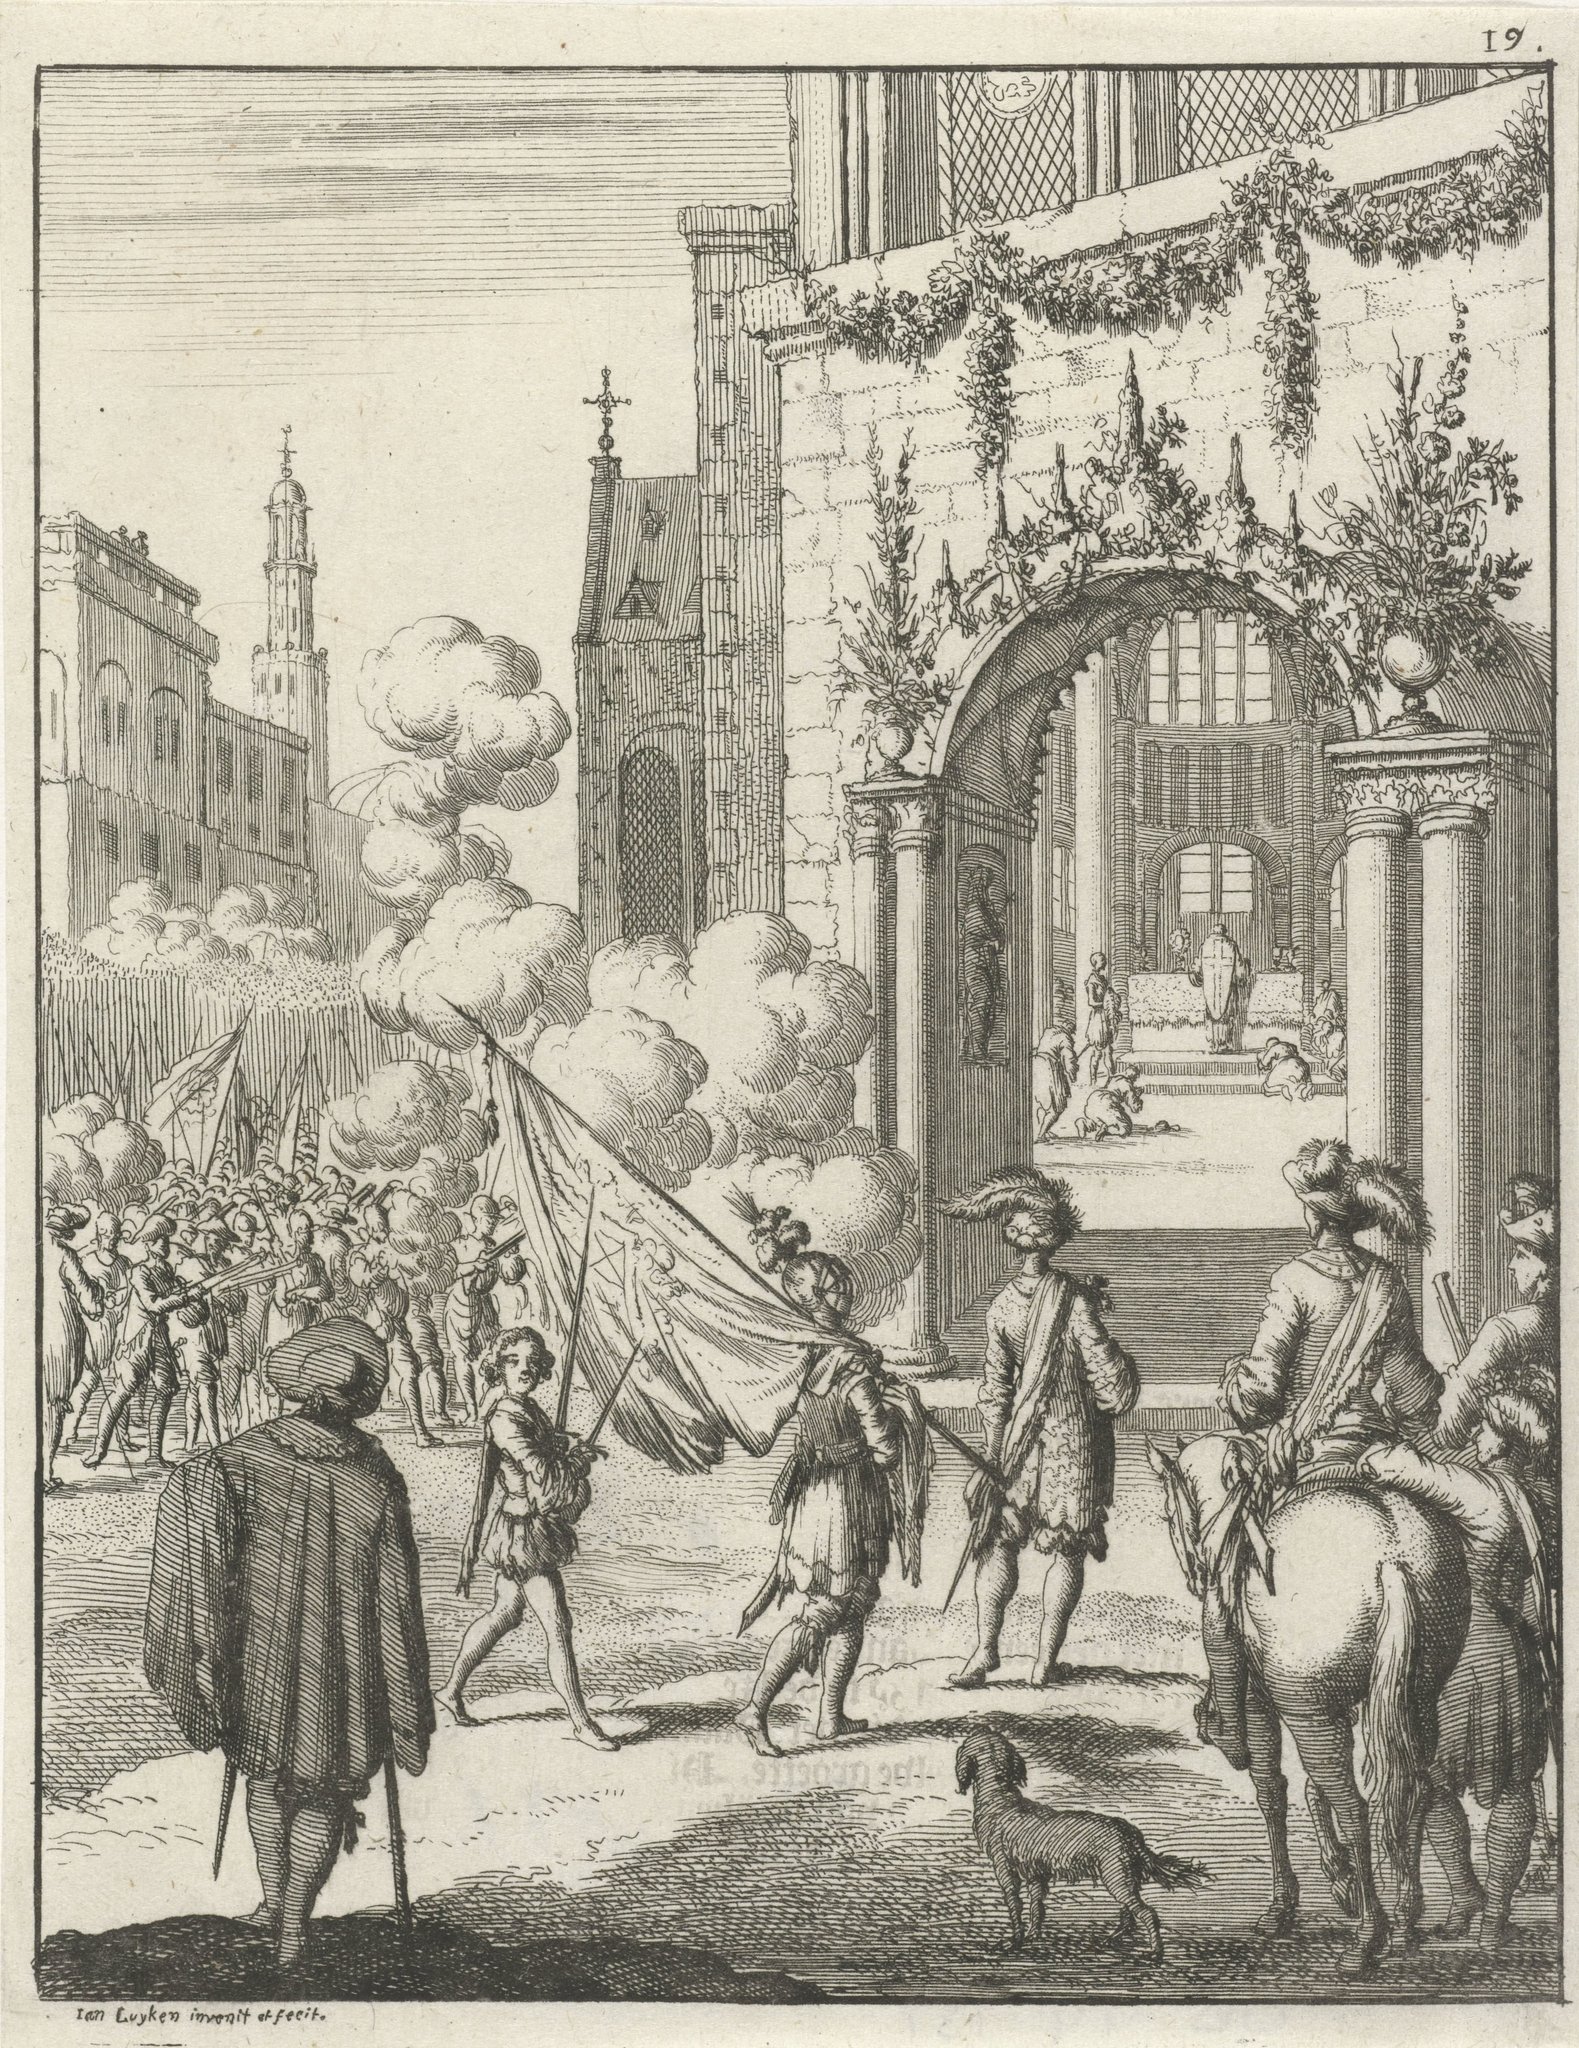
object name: print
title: Optocht naar een kerk op Malta ter viering van Maria-Geboorte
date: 1681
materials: paper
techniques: etching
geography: amsterdam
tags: roman catholic church (+ mary), birth of mary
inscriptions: collector's mark: Lugt 2228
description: Illustratie opgenomen in deel I van: Thevenot, Jean de. Gedenkwaardige en zeer naauwkeurige reizen van den heere de Thevenot. Amsterdam: Jan Bouman, 1681-1682.